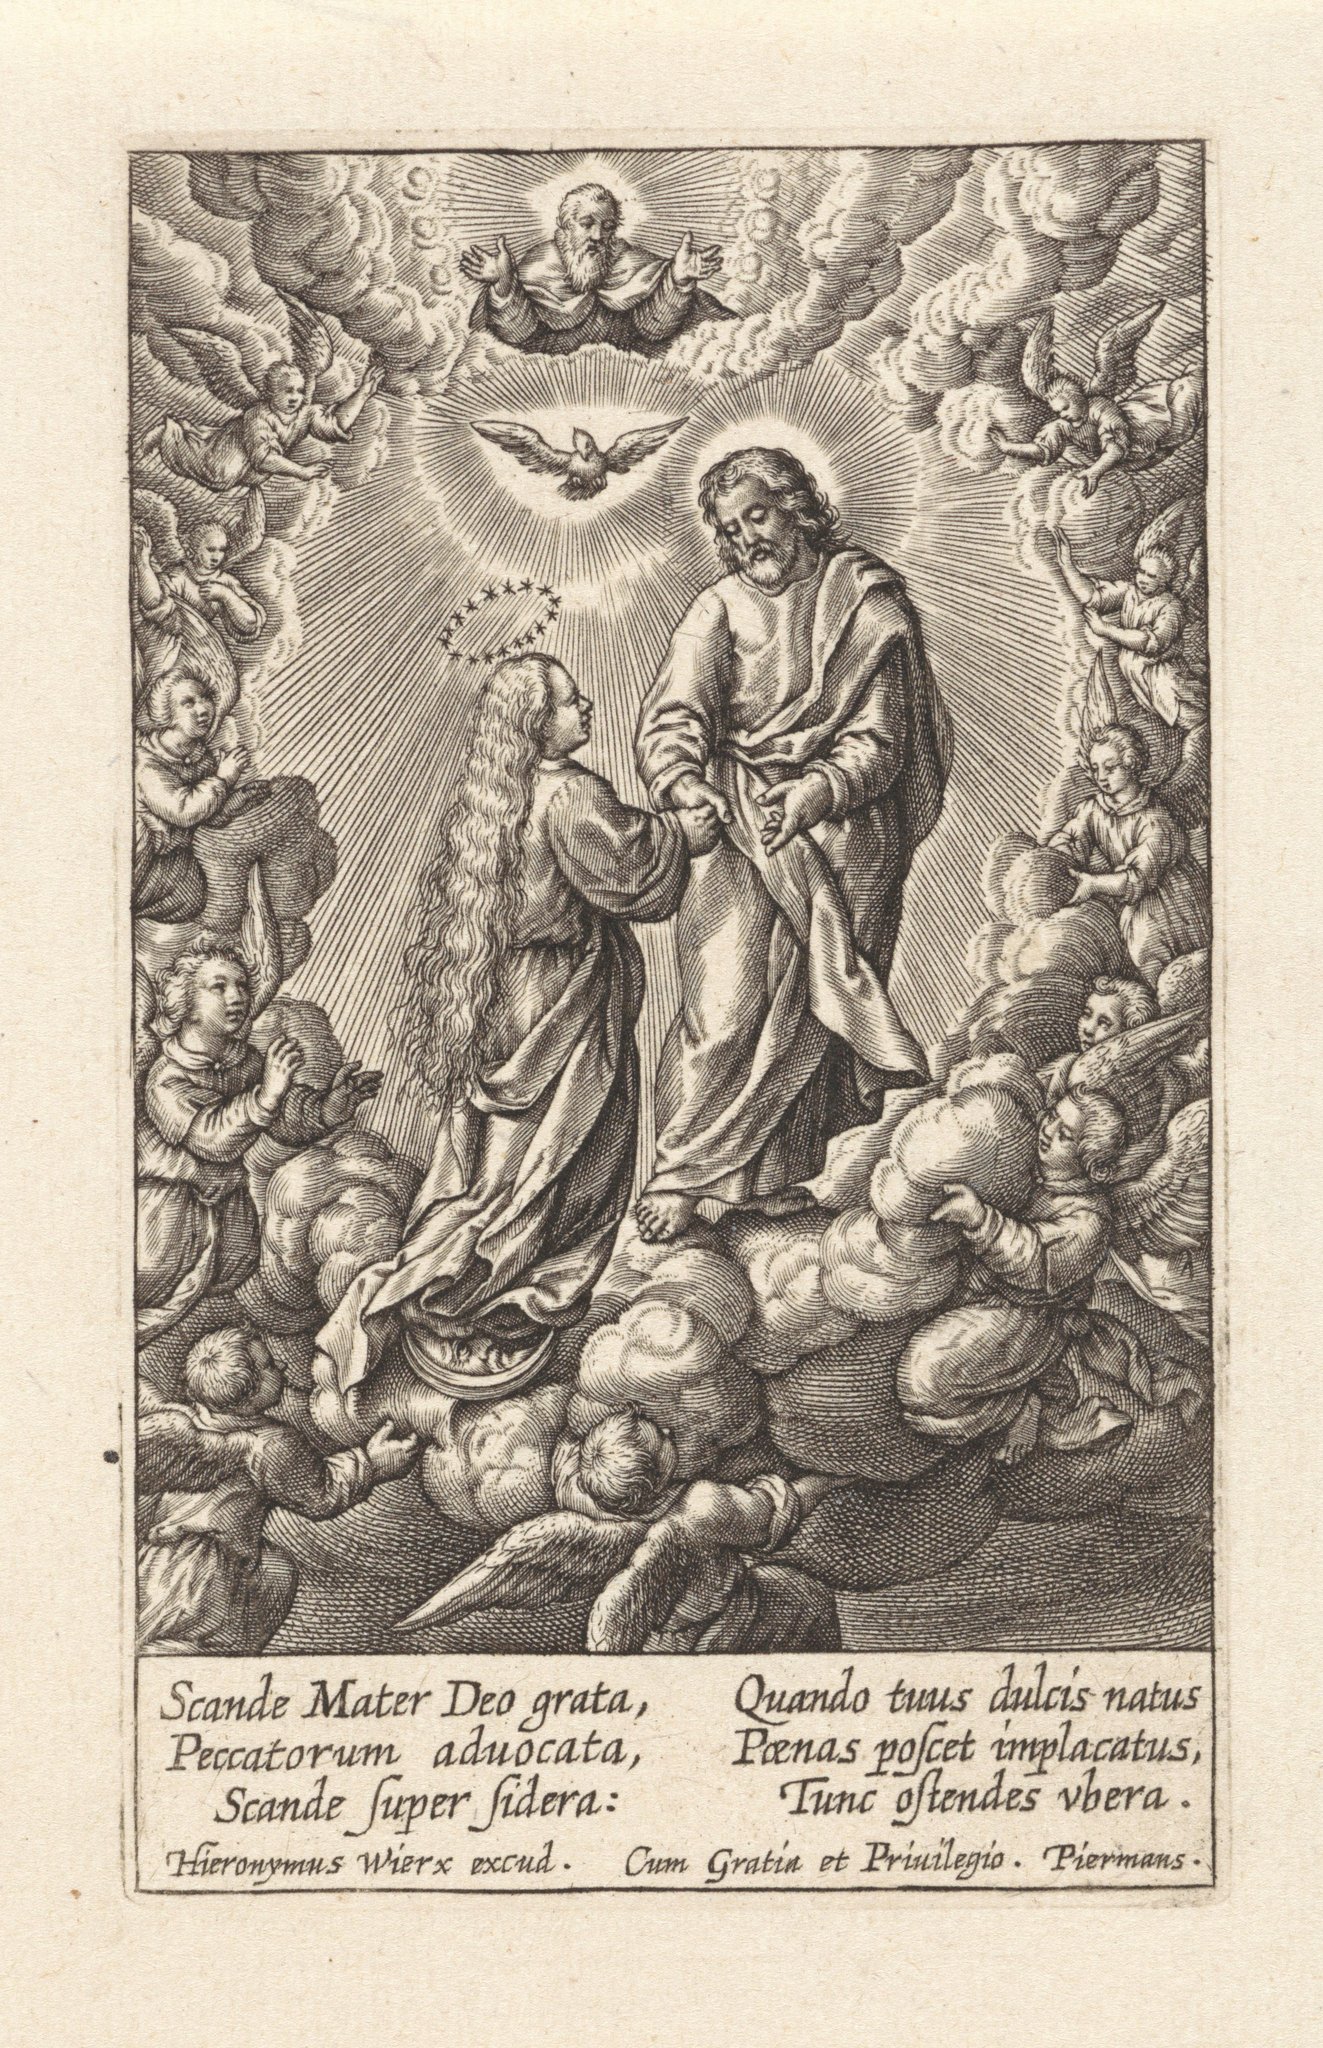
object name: print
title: Hemelvaart van Maria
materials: paper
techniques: engraving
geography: antwerp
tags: the assumption of mary ('assumptio corporis'): she is borne into heaven by angels (+ holy trinity)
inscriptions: collector's mark: Lugt 2228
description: Maria wordt op de maansikkel meegevoerd naar de hemel. Christus pakt haar hand vast. Boven hem de Heilige Geest als duif en God de Vader. Ze zijn omringd door engelen op de wolken. In de marge een zesregelig onderschrift, in twee kolommen, in het Latijn.